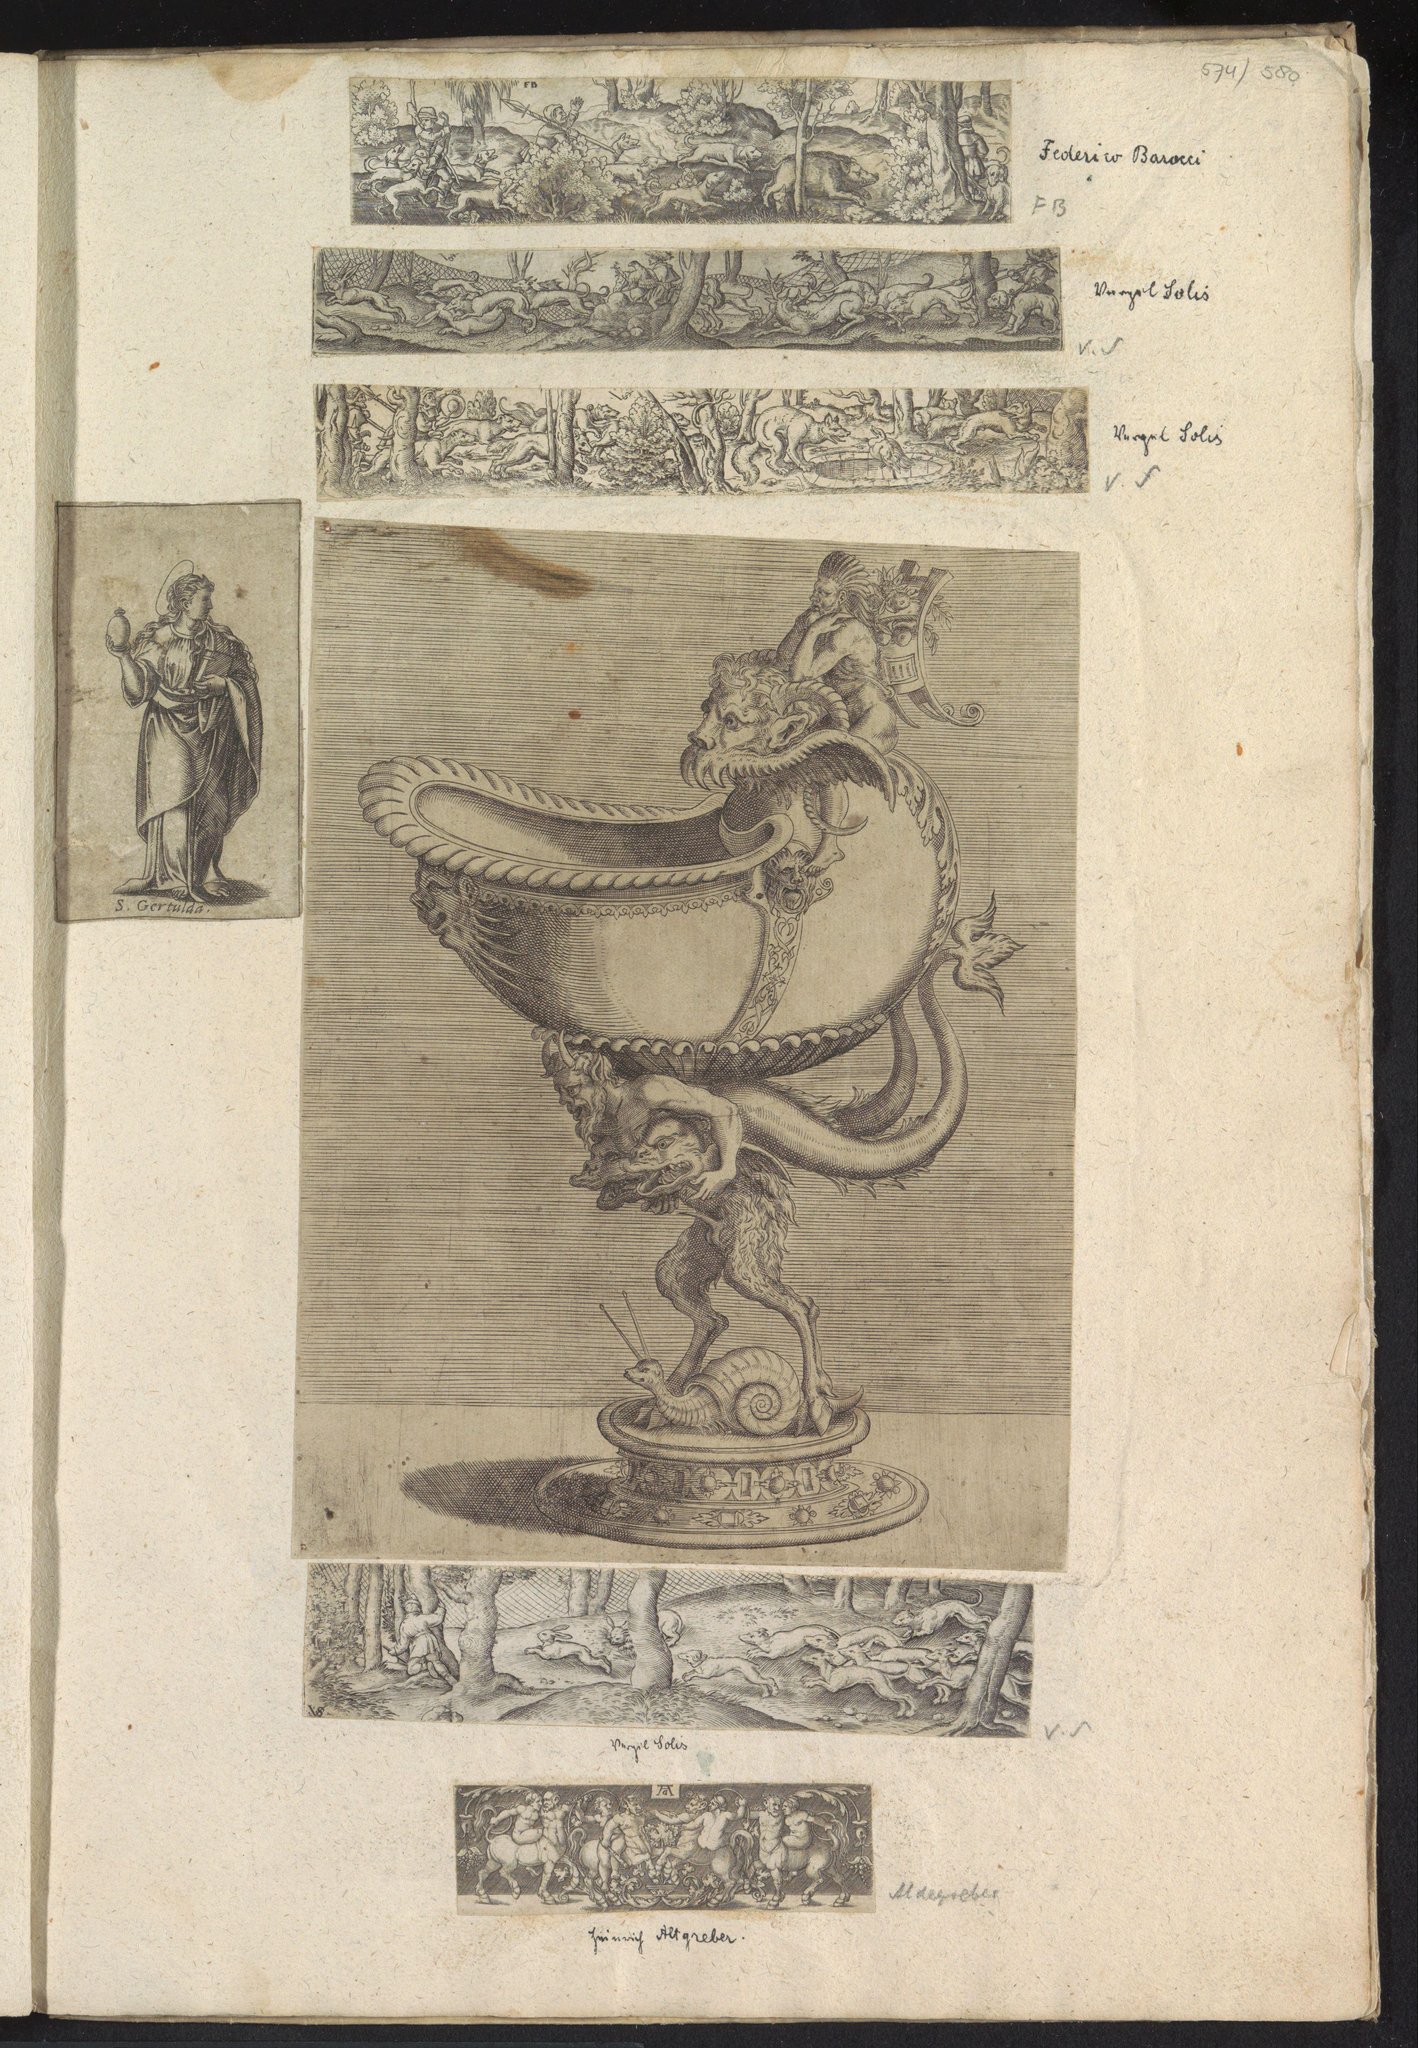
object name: ornament print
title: Albumblad met zeven prenten met jachtscènes, de heilige Gertulda, centauren en een nautilusbokaal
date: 1500-1599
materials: paper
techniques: engraving, etching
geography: netherlands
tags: kitchen-utensils: cauldron, centaurs, boar-hunting, hunters hunting (n.b.: in 1988-1990 this notation denoted the concept of 43c11421 'hunters resting during the hunt'), hunt ~ mammals, female saints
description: Albumblad met zeven uitgeknipte prenten: vier jachtscènes, de heilige Gertulda, centauren en een nautilusbokaal.